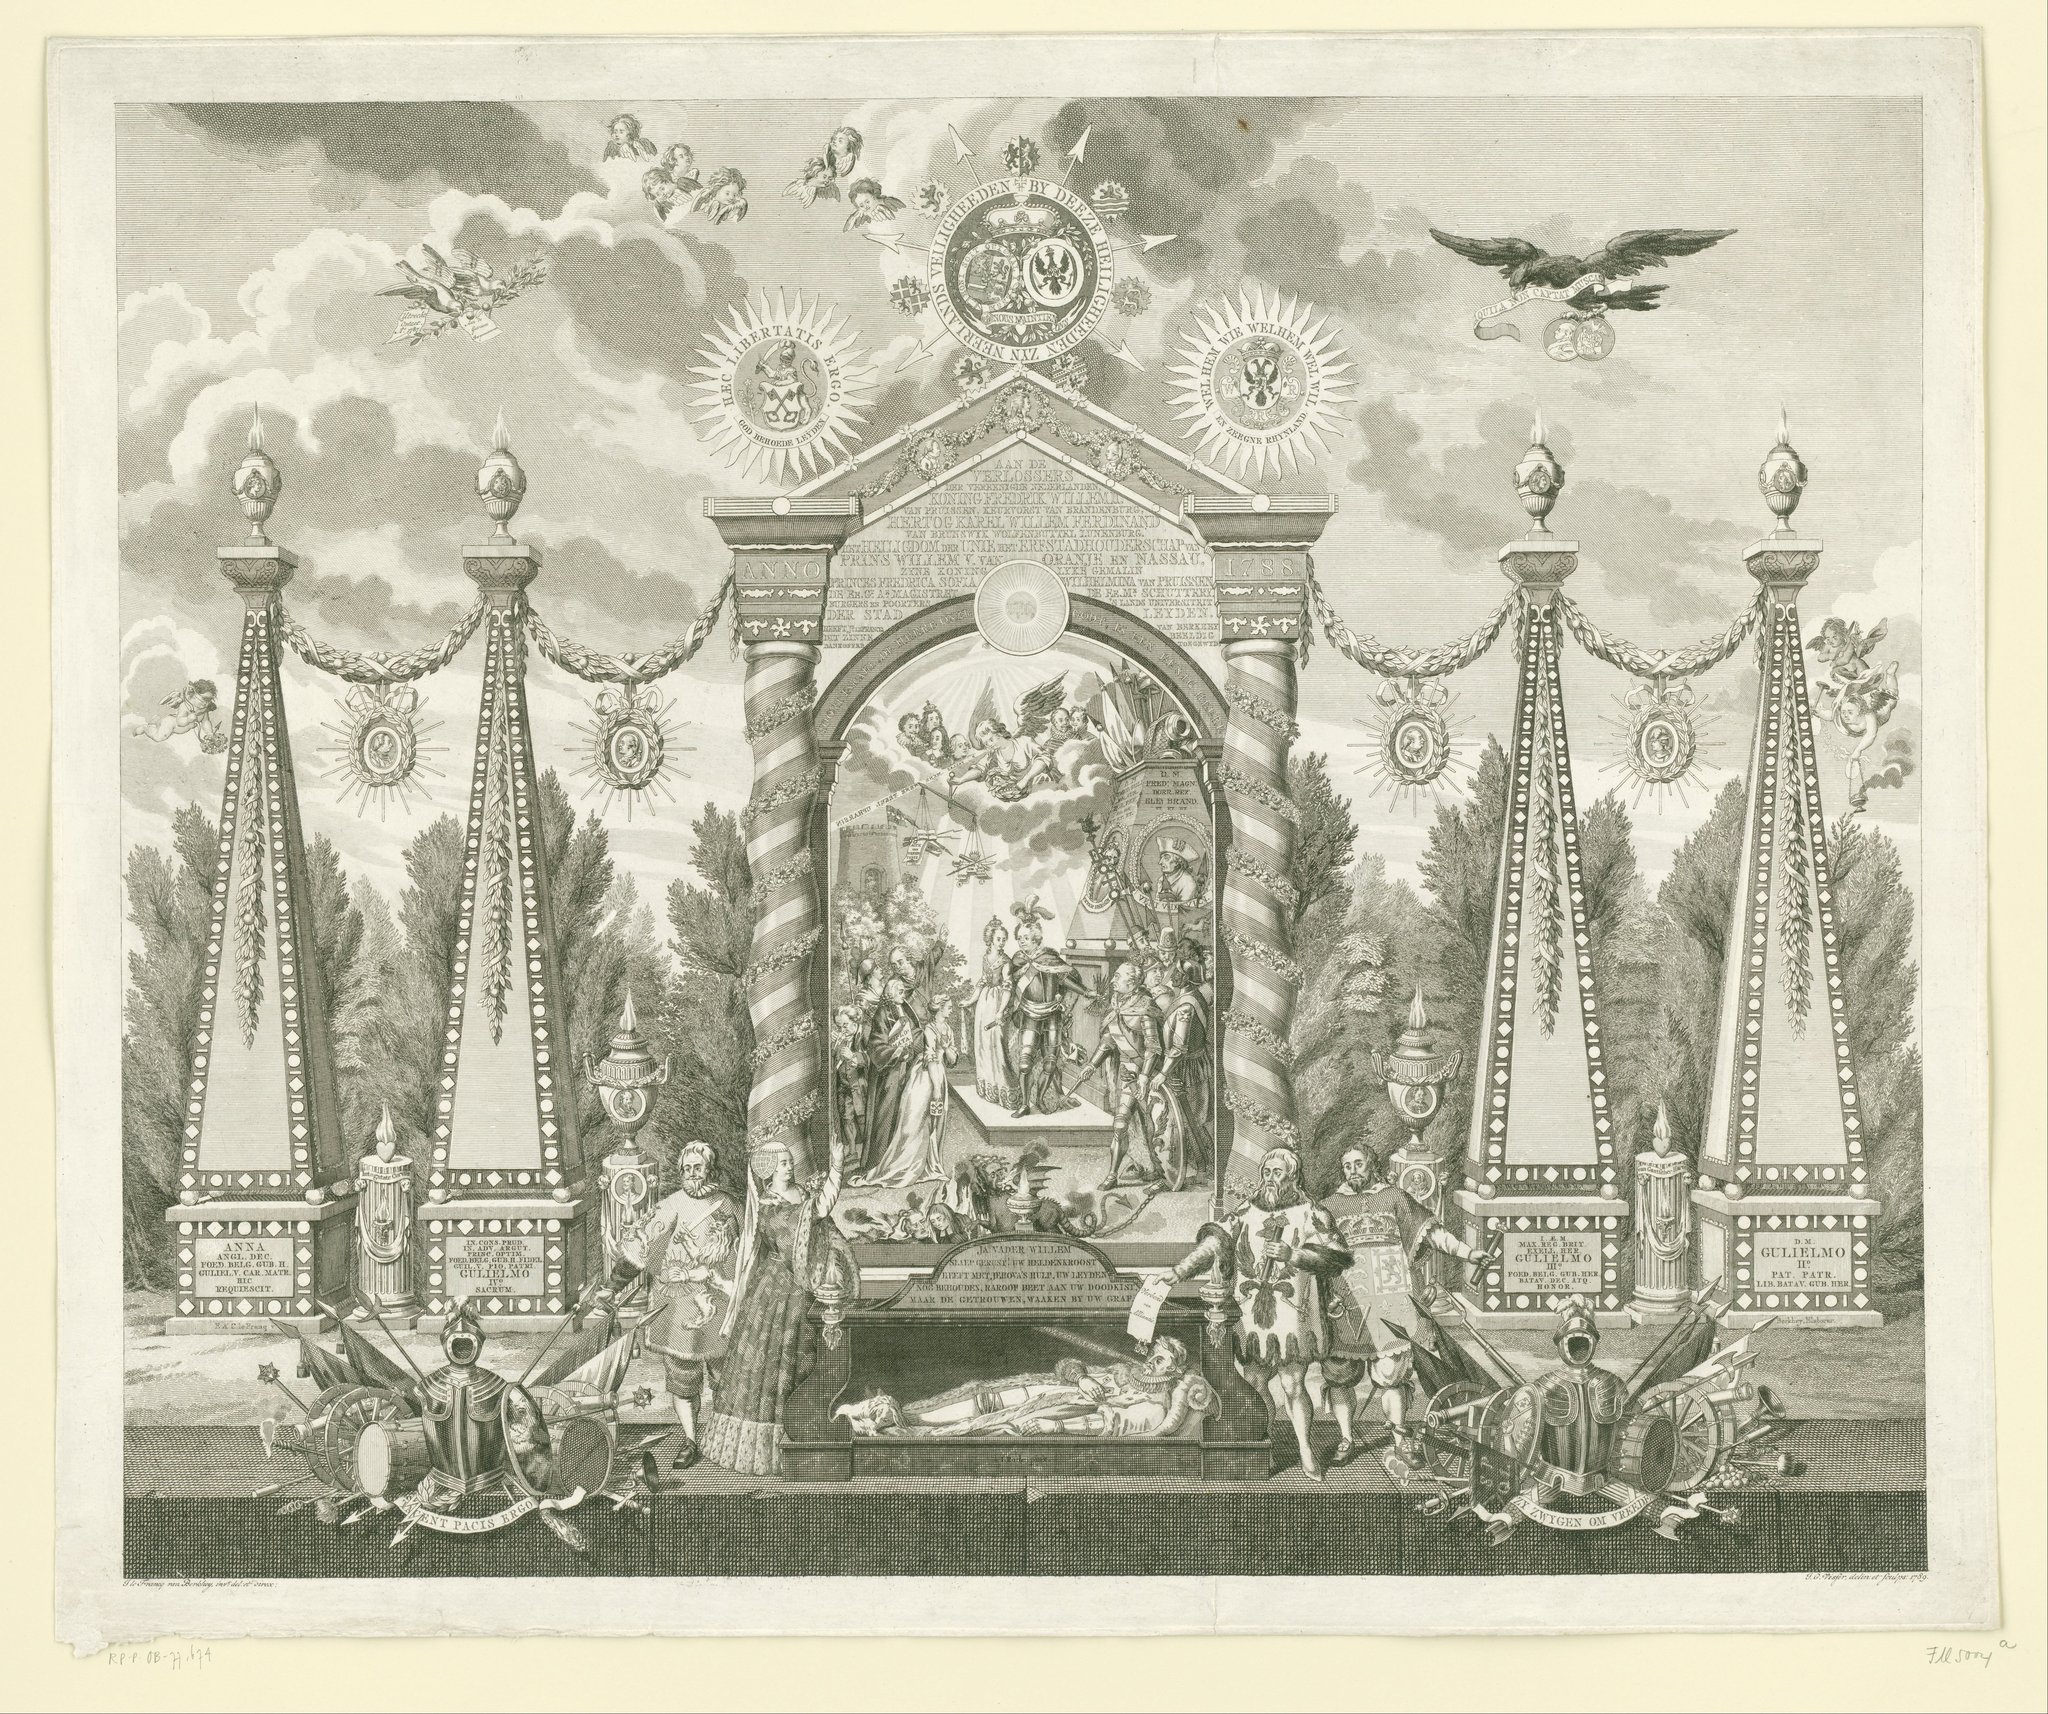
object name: print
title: Allegorie ter ere van de koning van Pruisen voor zijn herstel van het stadhouderschap van Willem V, 1788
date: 1789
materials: paper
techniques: engraving, etching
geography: northern netherlands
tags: william v (prince of orange), frederik willem ii (koning van pruisen), william i (prince of orange), berlin, painter, draughtsman, wilhelmina of prussia (princess of orange), obelisk, needle, grave, tomb, monument, statue, stadtholder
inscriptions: collector's mark: Lugt 2228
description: Allegorie ter ere van de koning van Pruisen voor zijn herstel van het stadhouderschap van Willem V, 1788. Ereboog met prins Willem V en prinses Wilhelmina voor een monument, rechts de koning van Pruisen en de hertog van Brunswijk. Onderaan prins Willem I in zijn graftombe. Aan weerszijden obelisken ter ere van Willem II, III en IV en prinses Anna. Op de voorgrond de herauten van Nederland, 's Lands Unie, Groot-Brittannië en Pruisen en twee wapentrofeeën. Bij de prent behoort een tekstblad.